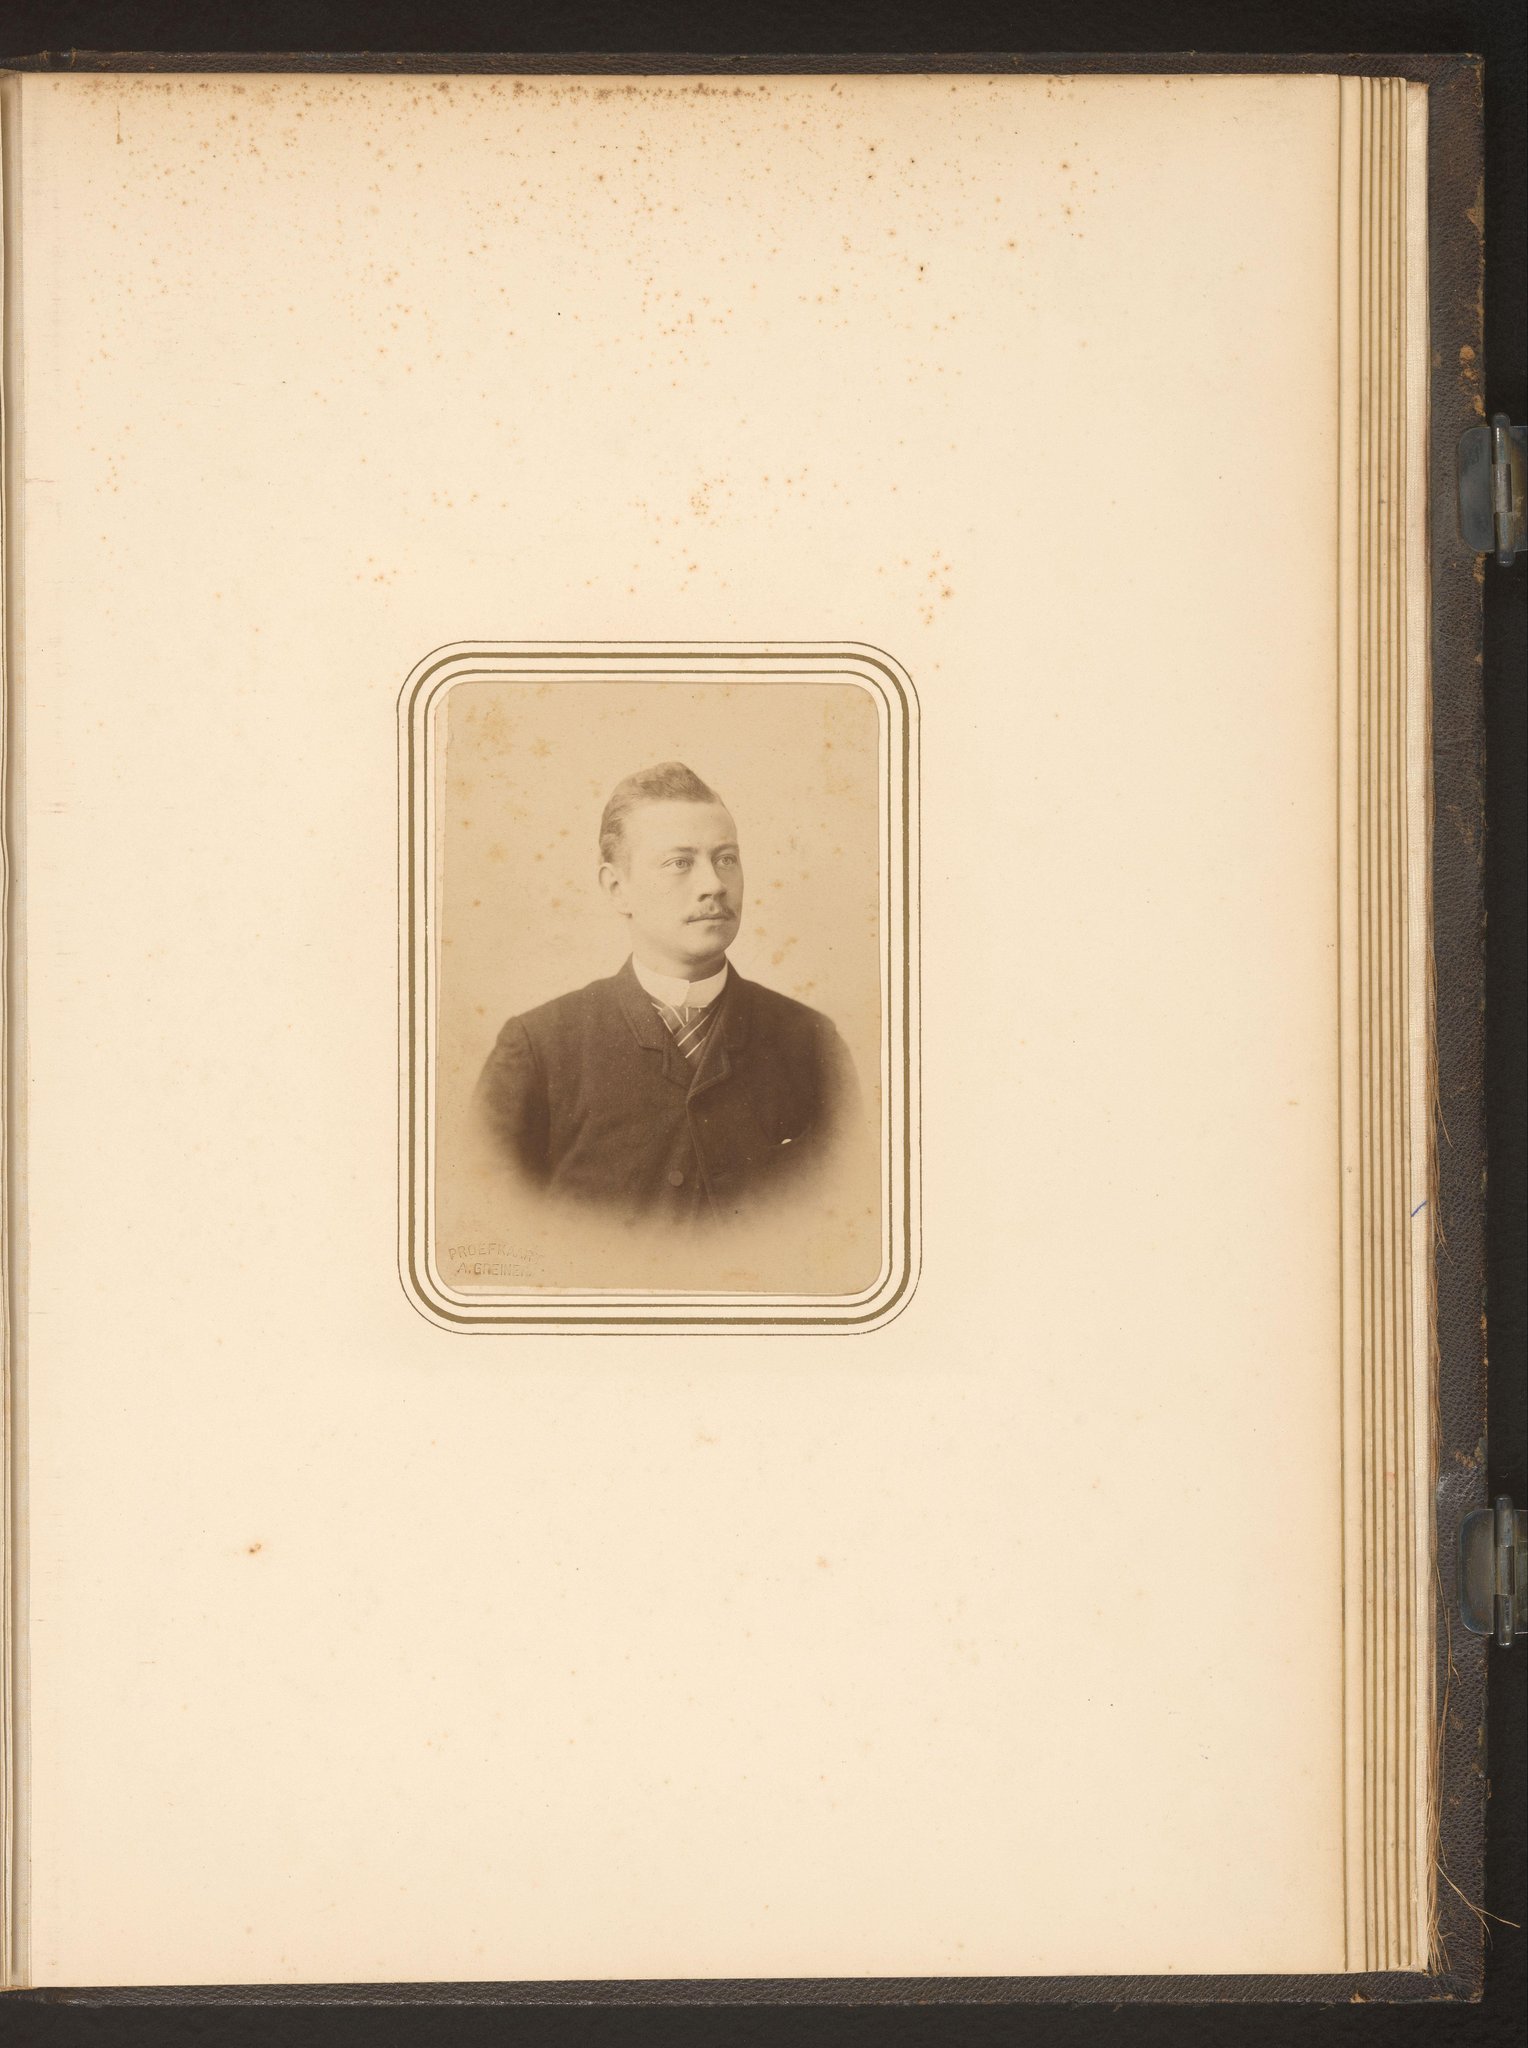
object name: cabinet photograph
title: Portret van onbekende man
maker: albert greiner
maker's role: fotograaf, fotostudio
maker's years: 1833-1890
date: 1882-1887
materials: cardboard, photographic support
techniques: albumen print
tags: historical persons not known by name, sumatra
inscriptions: name: ‘Proefkaart A. Greiner’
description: Portret van een onbekende man. Ingestoken foto in het herinneringsalbum aangeboden door de Tabak Maatschappij Arendsburg aan hoofdadministrateur M.J. Tiele bij zijn terugkeer naar Nederland in 1887.